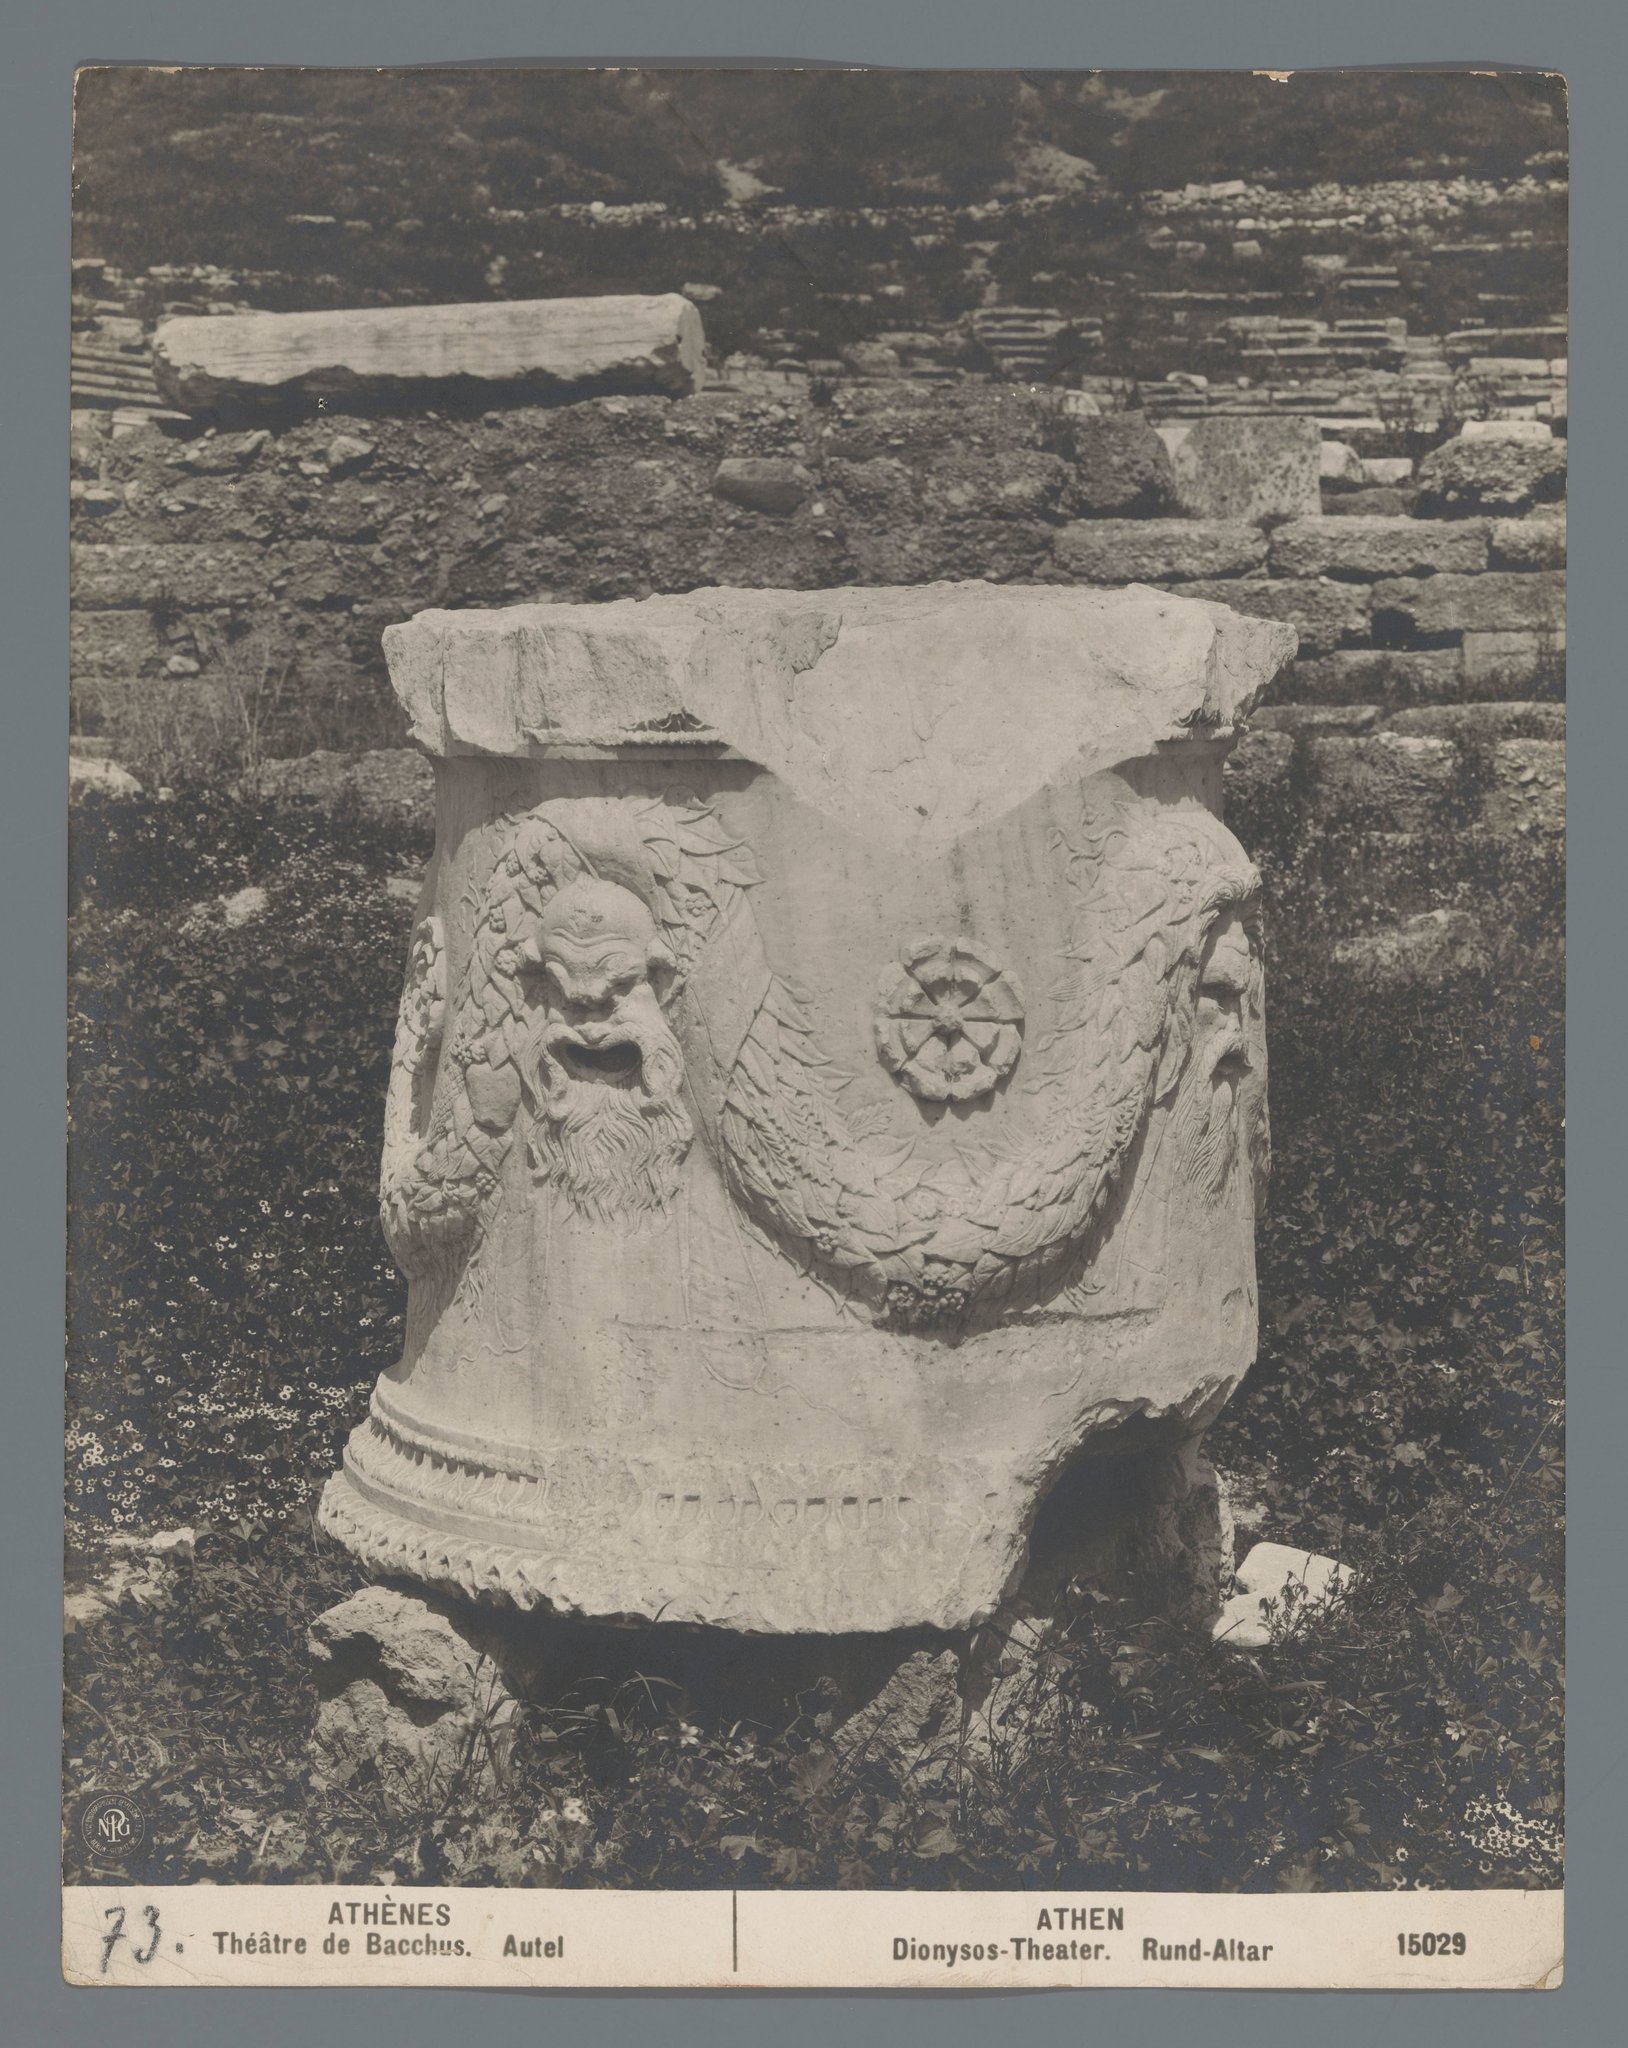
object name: photograph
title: ATHÈNES Théâtre de Bacchus. Autel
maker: Anonymous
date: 1875-1900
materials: photographic support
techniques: gelatin silver print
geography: athens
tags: altar ~ non-christian religions, mask, mascaron ~ ornament, foliage, tendrils, branches ~ ornament, sculpture (+ relief ~ sculpture)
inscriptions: name: ‘NPG NEUE PHOTOGRAPHISCHE GESELLSCHAFT A G BERLIN - STEGLITZ 1905’, inscription: ‘12028 - OV’, annotation: ‘II. WAHL’, number: ‘15029’, number: ‘73.’, collector's mark: ‘RIJKS-NORMAALSCHOOL voor TEEKENONDERWIJZERS AMSTERDAM’